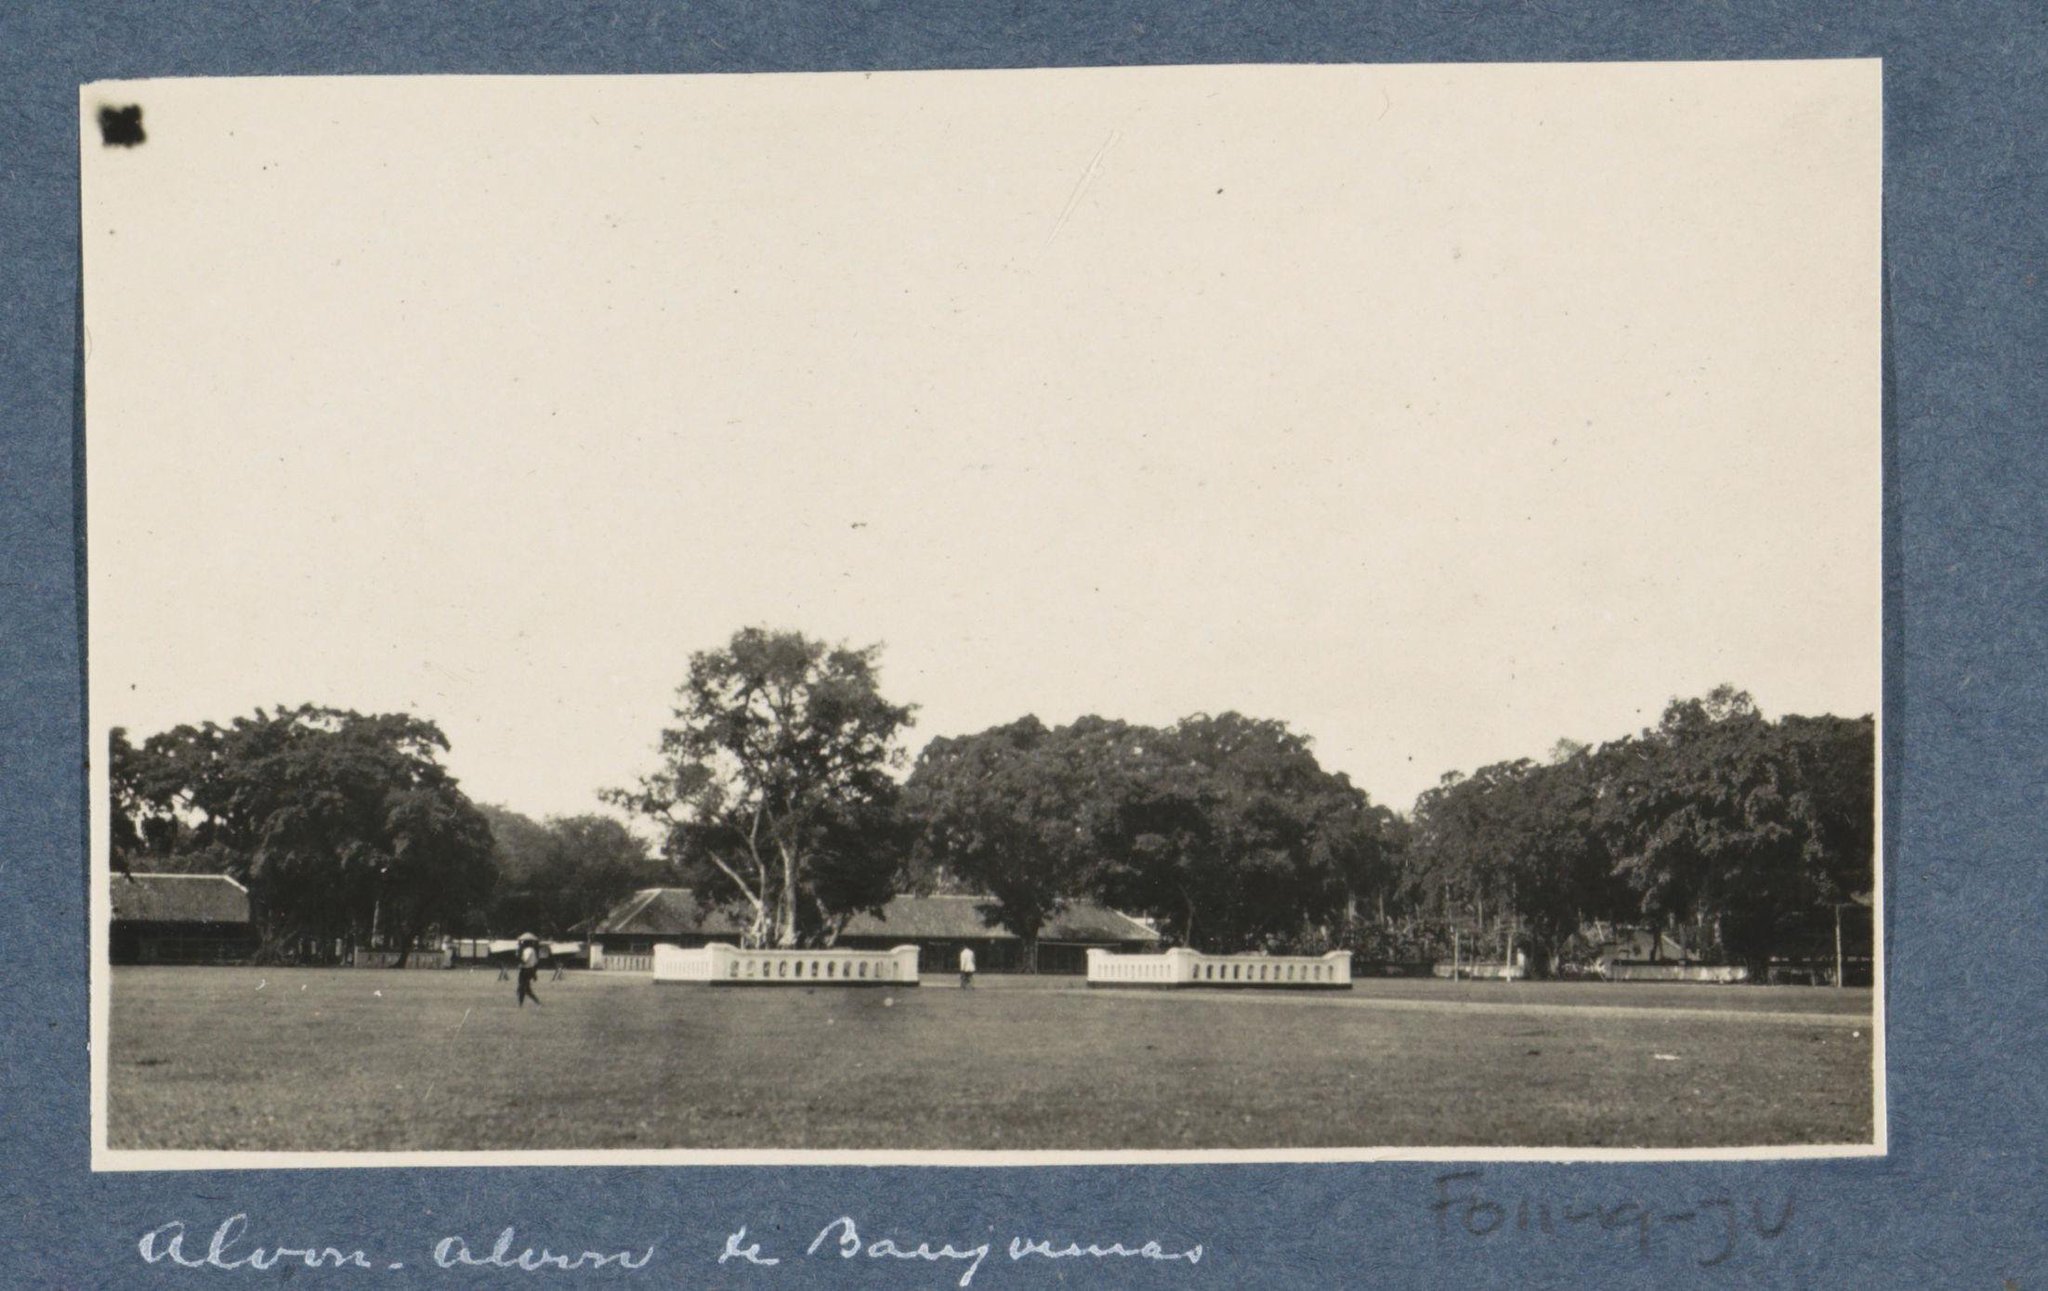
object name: album leaf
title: Weg met daarnaast een spoorlijn op Java, in een auto een vrouw aangeduid als 'Henny'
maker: Anonymous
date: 1900-1920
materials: paper, photographic support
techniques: gelatin silver print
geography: java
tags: road, path, railway, train, automobile, java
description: Onderdeel van reisalbum met foto's van bedrijvigheid en bezienswaardigheden op Sumatra en Java en van de reis naar en van Nederlands-Indië.